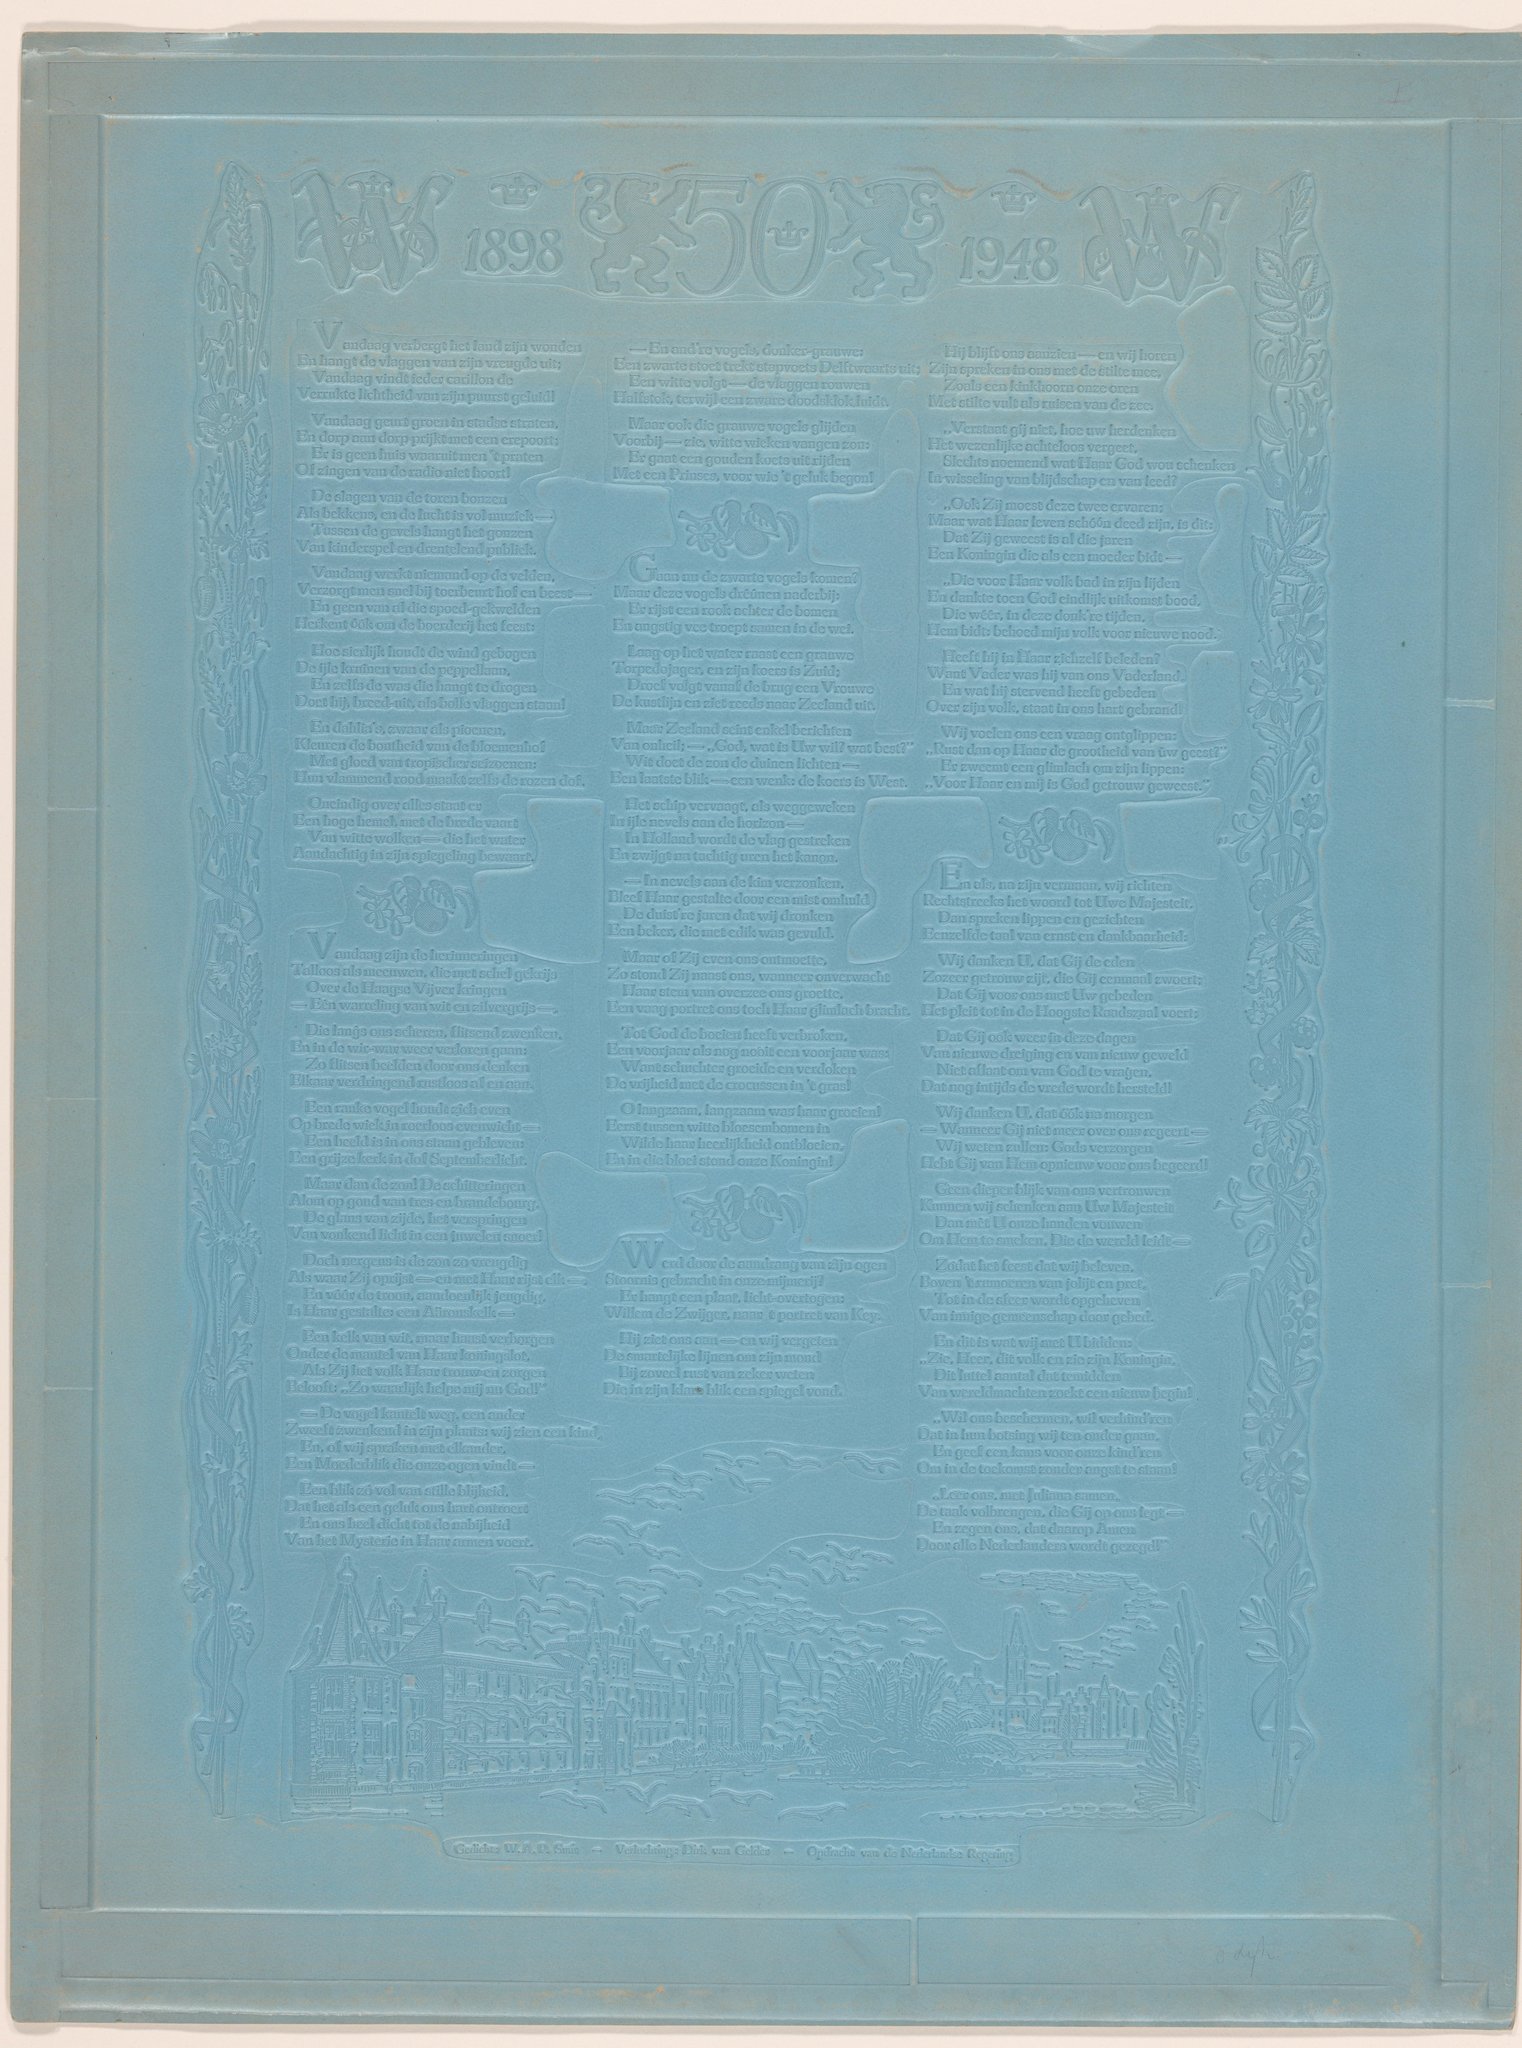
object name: letter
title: Houtgravures en documenten van de Haagse houtgraveur-school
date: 1840-1880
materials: paper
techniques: engraving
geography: netherlands